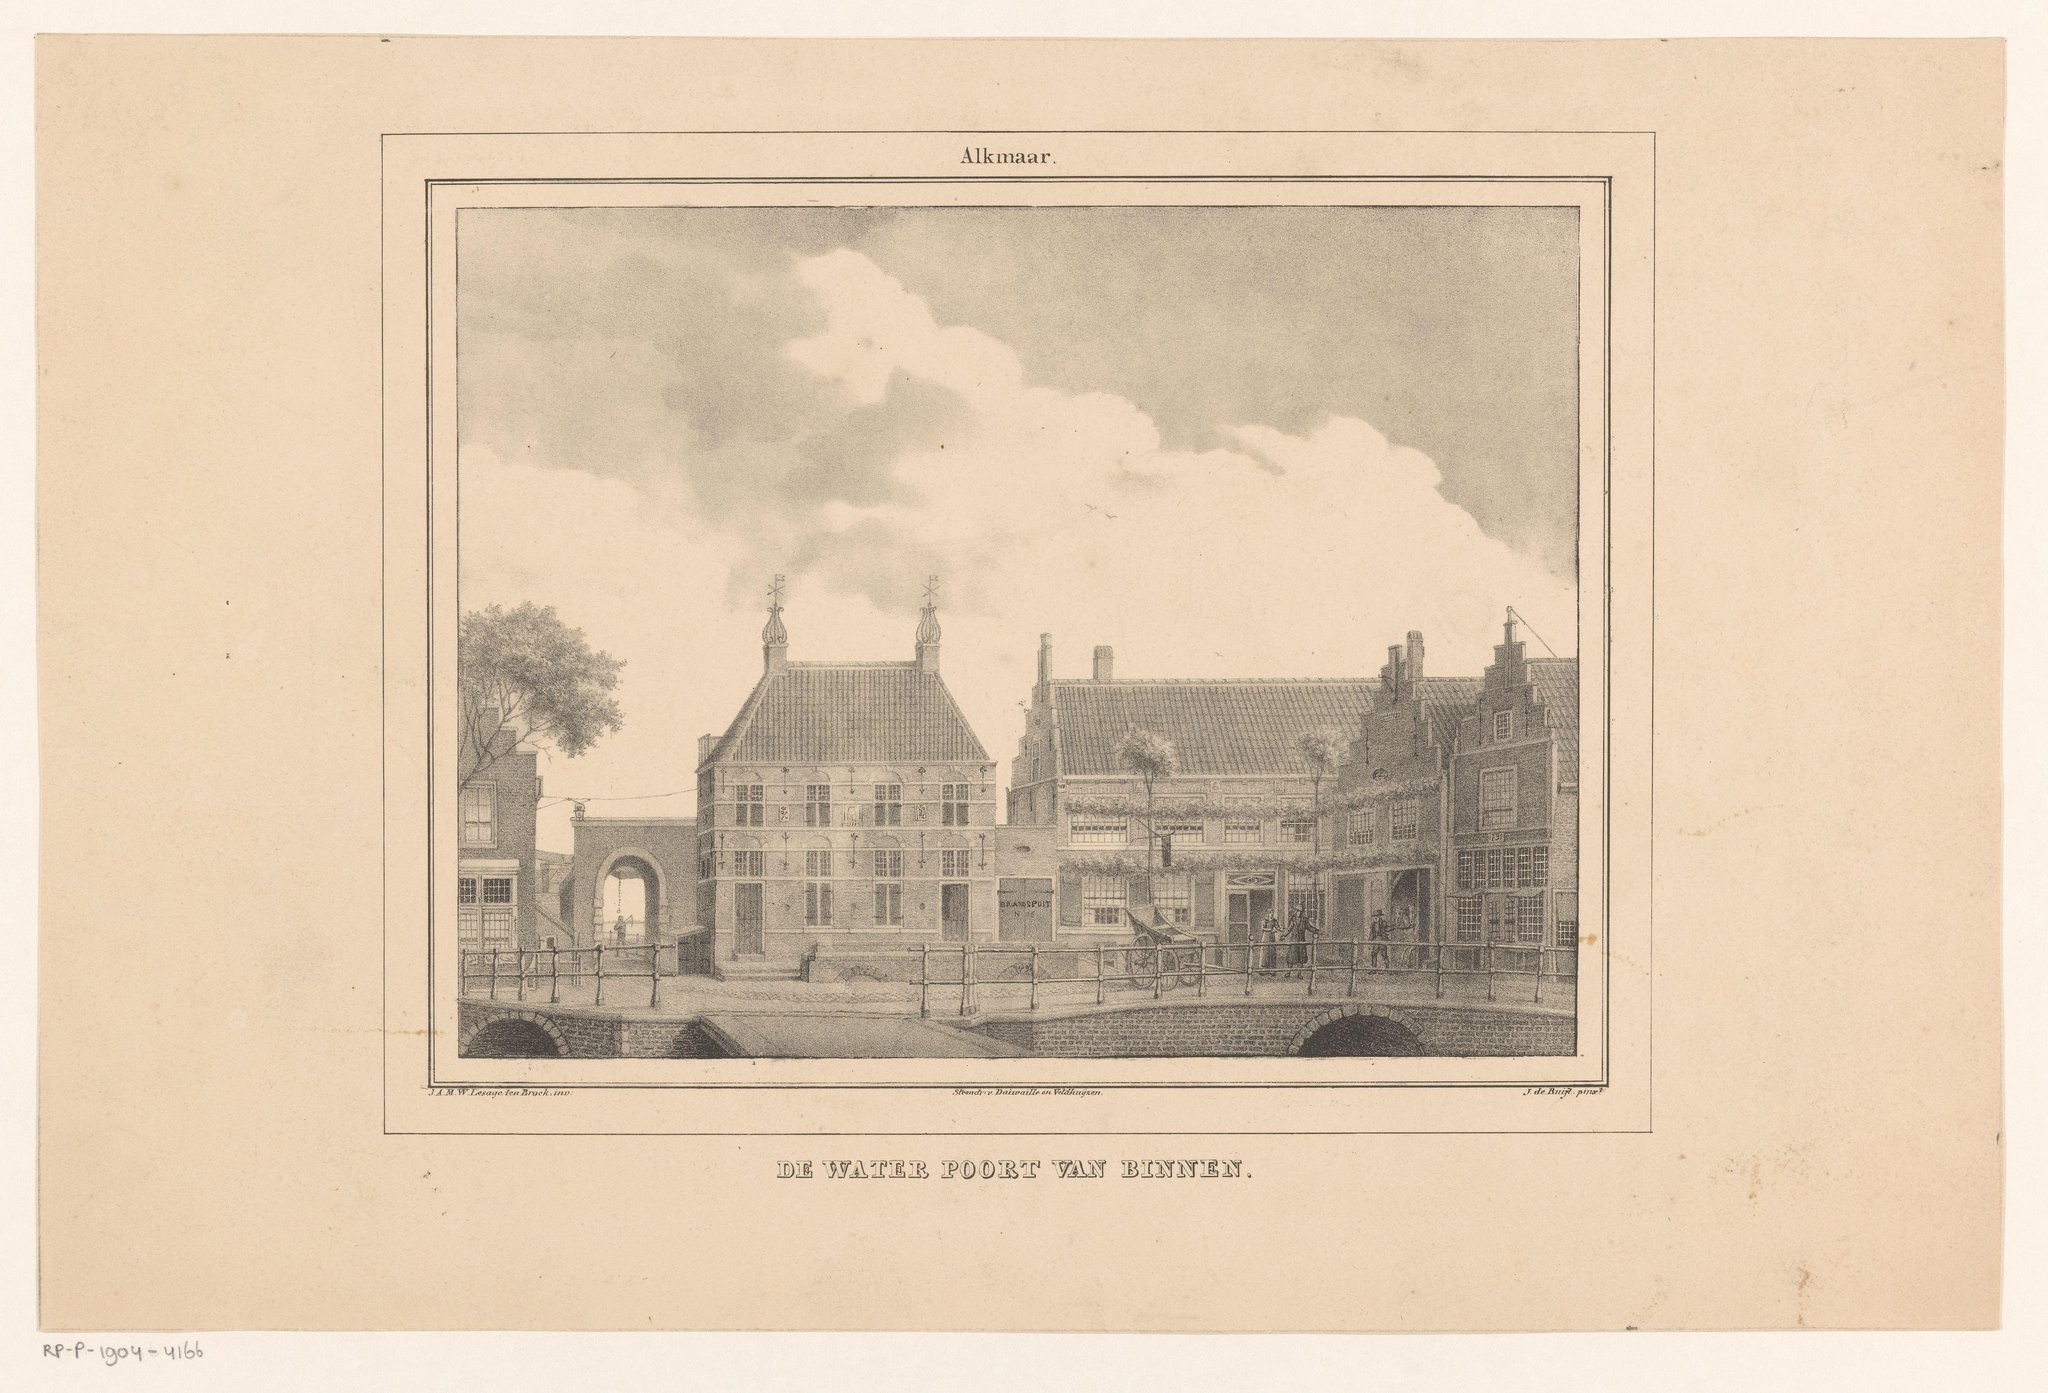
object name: print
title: Waterpoort in Alkmaar van binnen gezien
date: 1831-1835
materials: paper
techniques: lithograph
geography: alkmaar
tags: four-wheeled, animal-drawn vehicle, e.g.: cab, carriage, coach, city-gate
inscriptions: collector's mark: Lugt 2228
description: Op een deur rechts van de poort staat: 'brandspuit no. 5'. Rechts worden twee paarden uit een stal geleid naar een rijtuig.